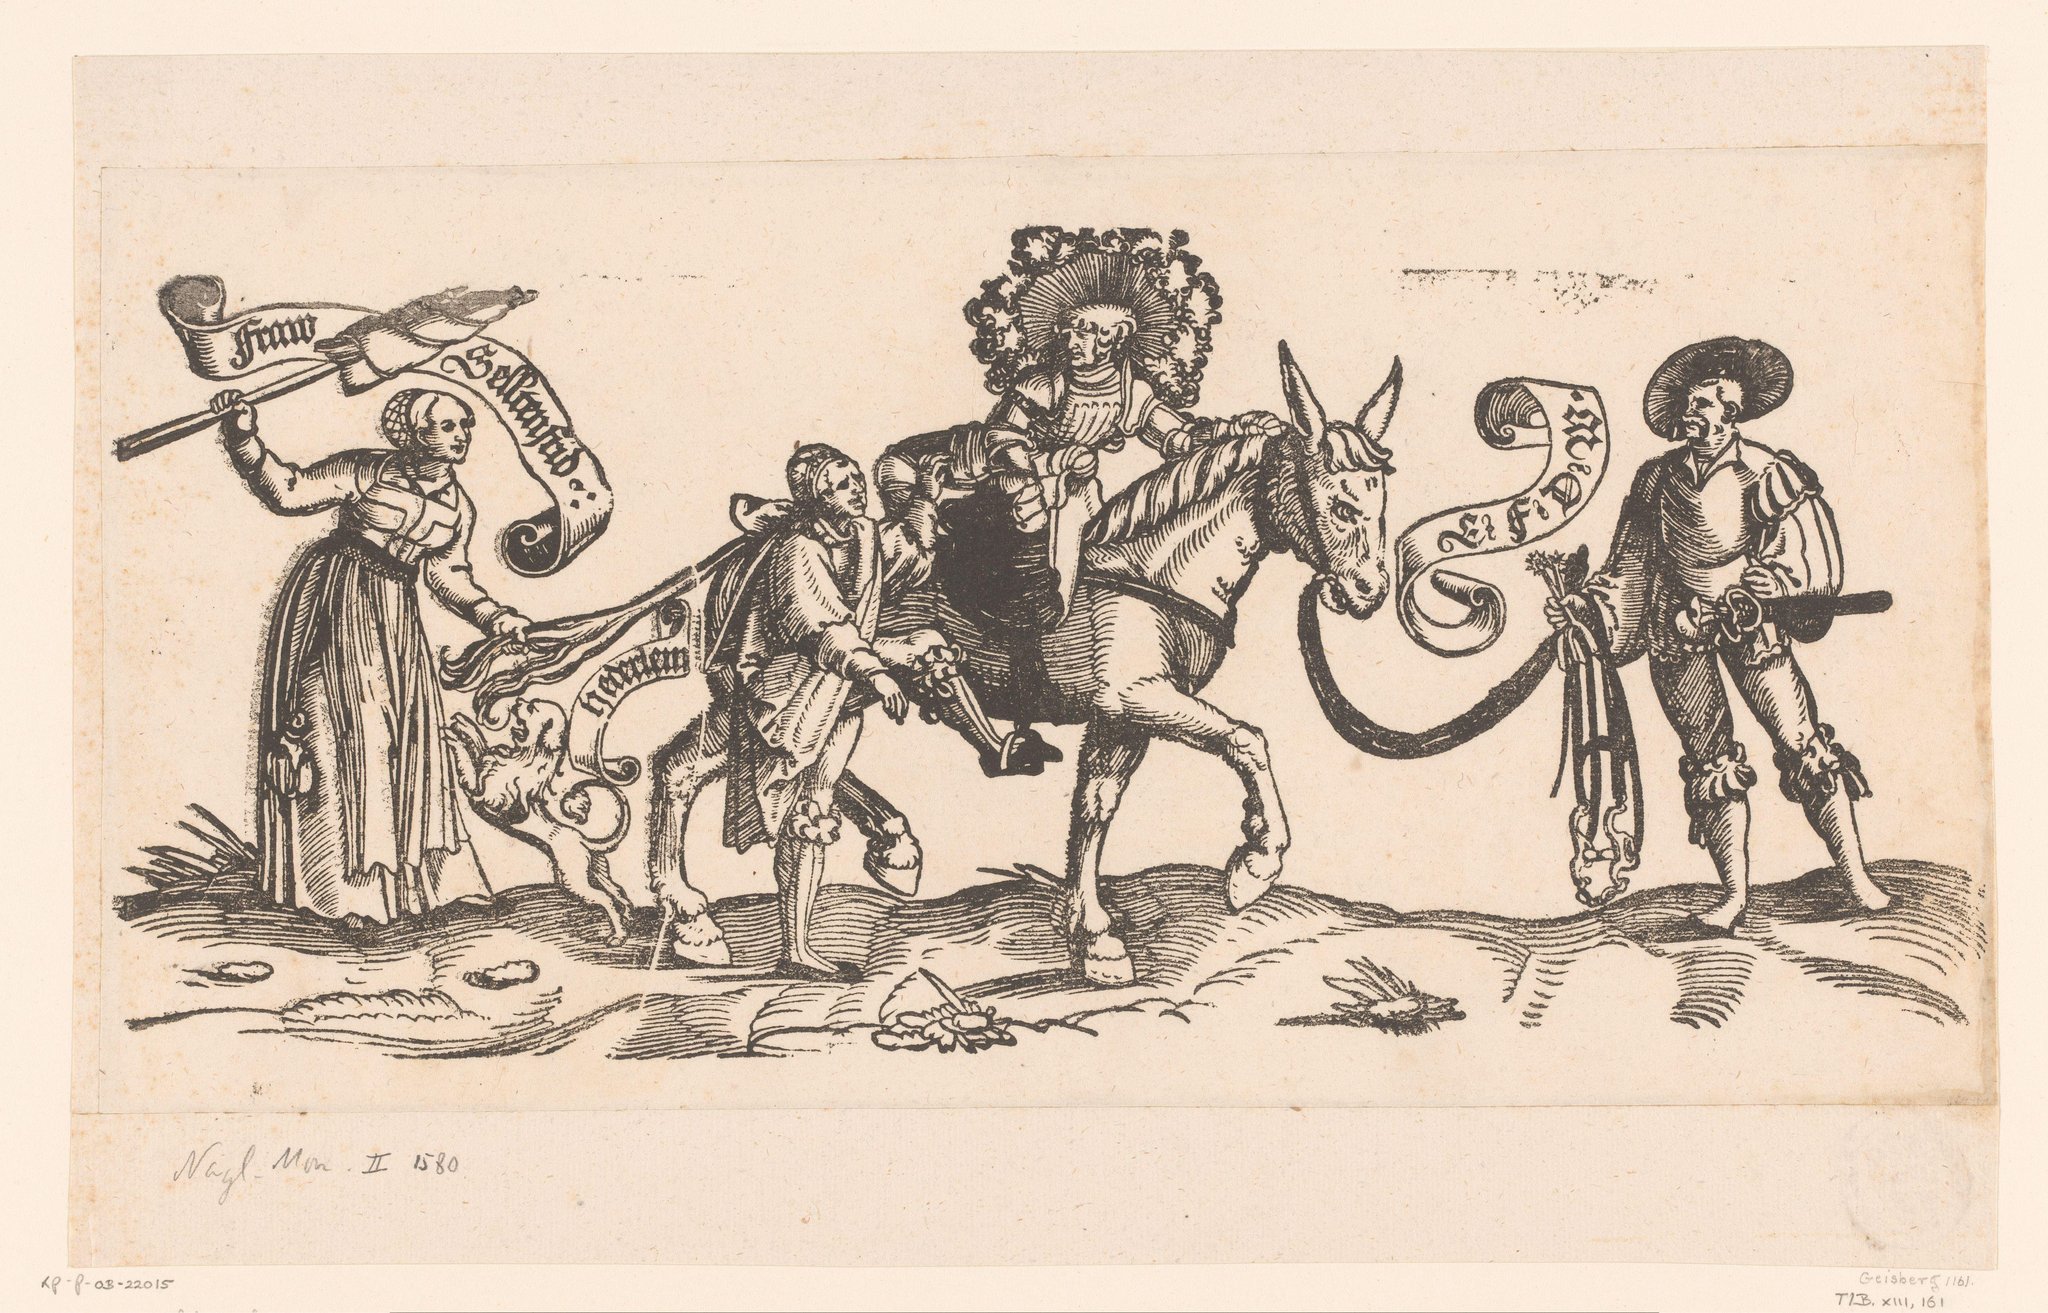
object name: print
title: Satire met een vrouw die een ezel vast houdt bij de staart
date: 1535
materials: paper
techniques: woodcut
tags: symbolic representations, allegories and emblems ~ satirical poetry; 'poema satirico' (ripa)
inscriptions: collector's mark: Lugt 240